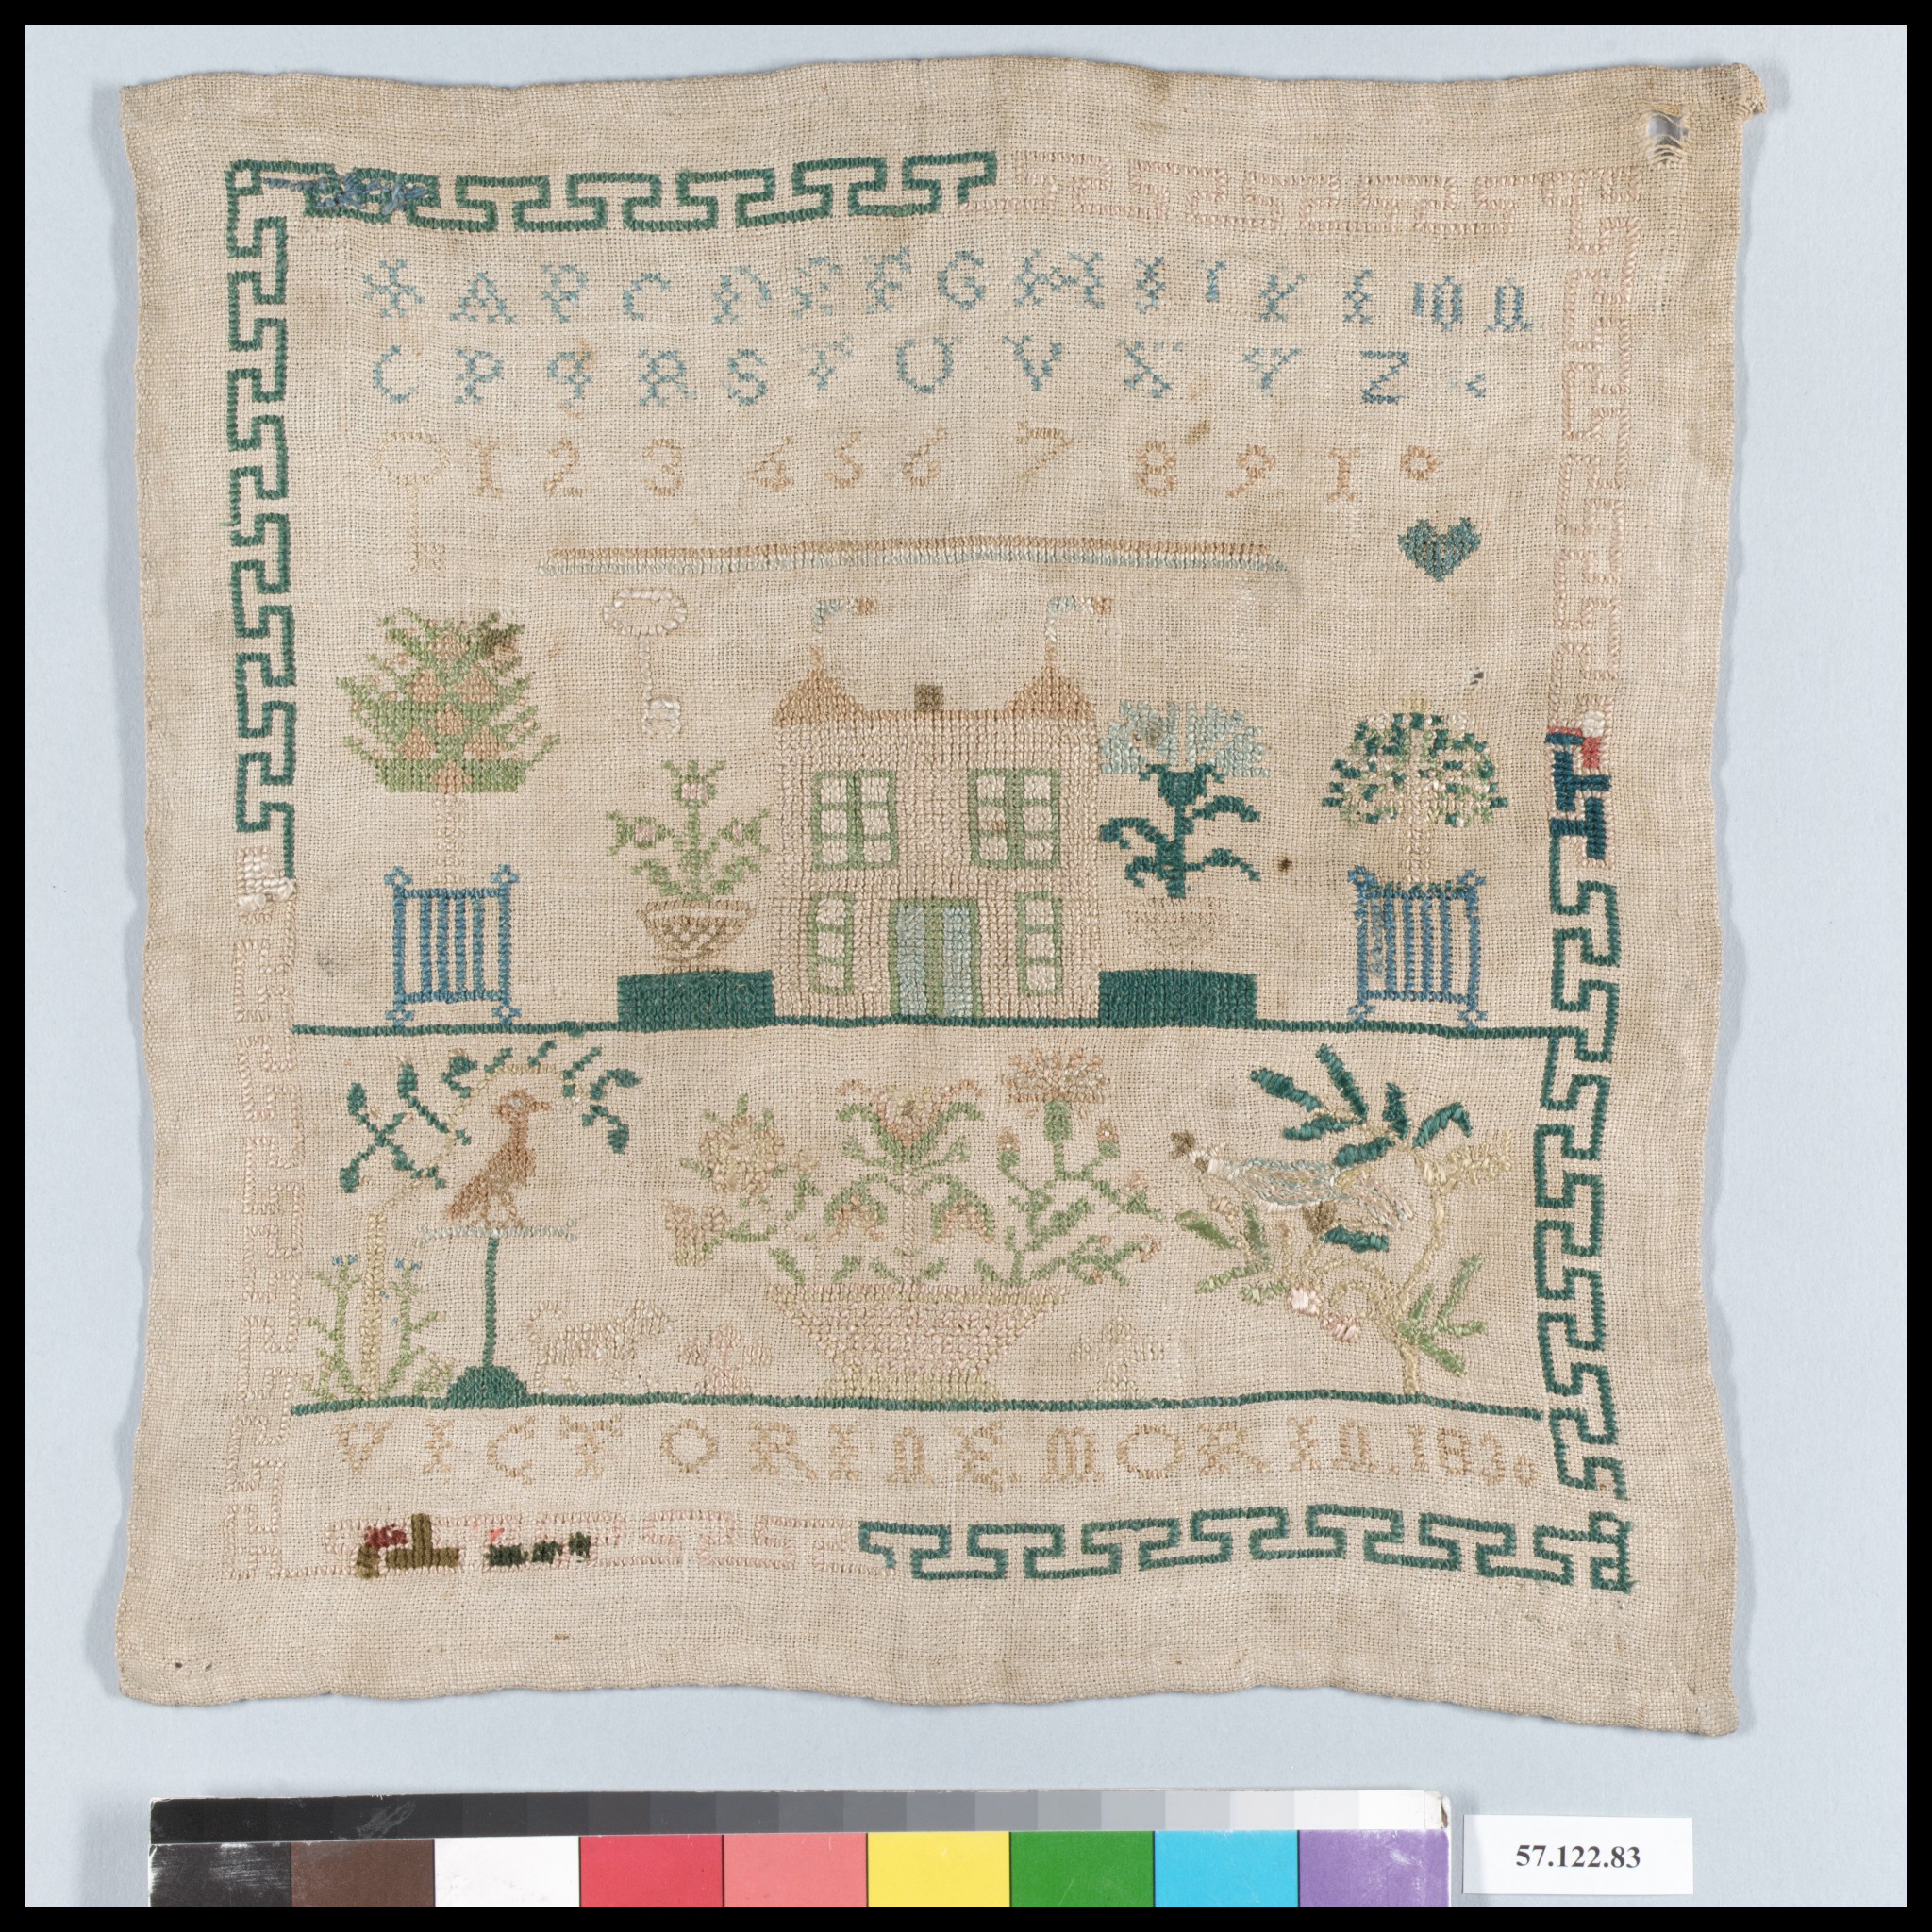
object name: sampler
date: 1830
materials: linen, silk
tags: houses,plants